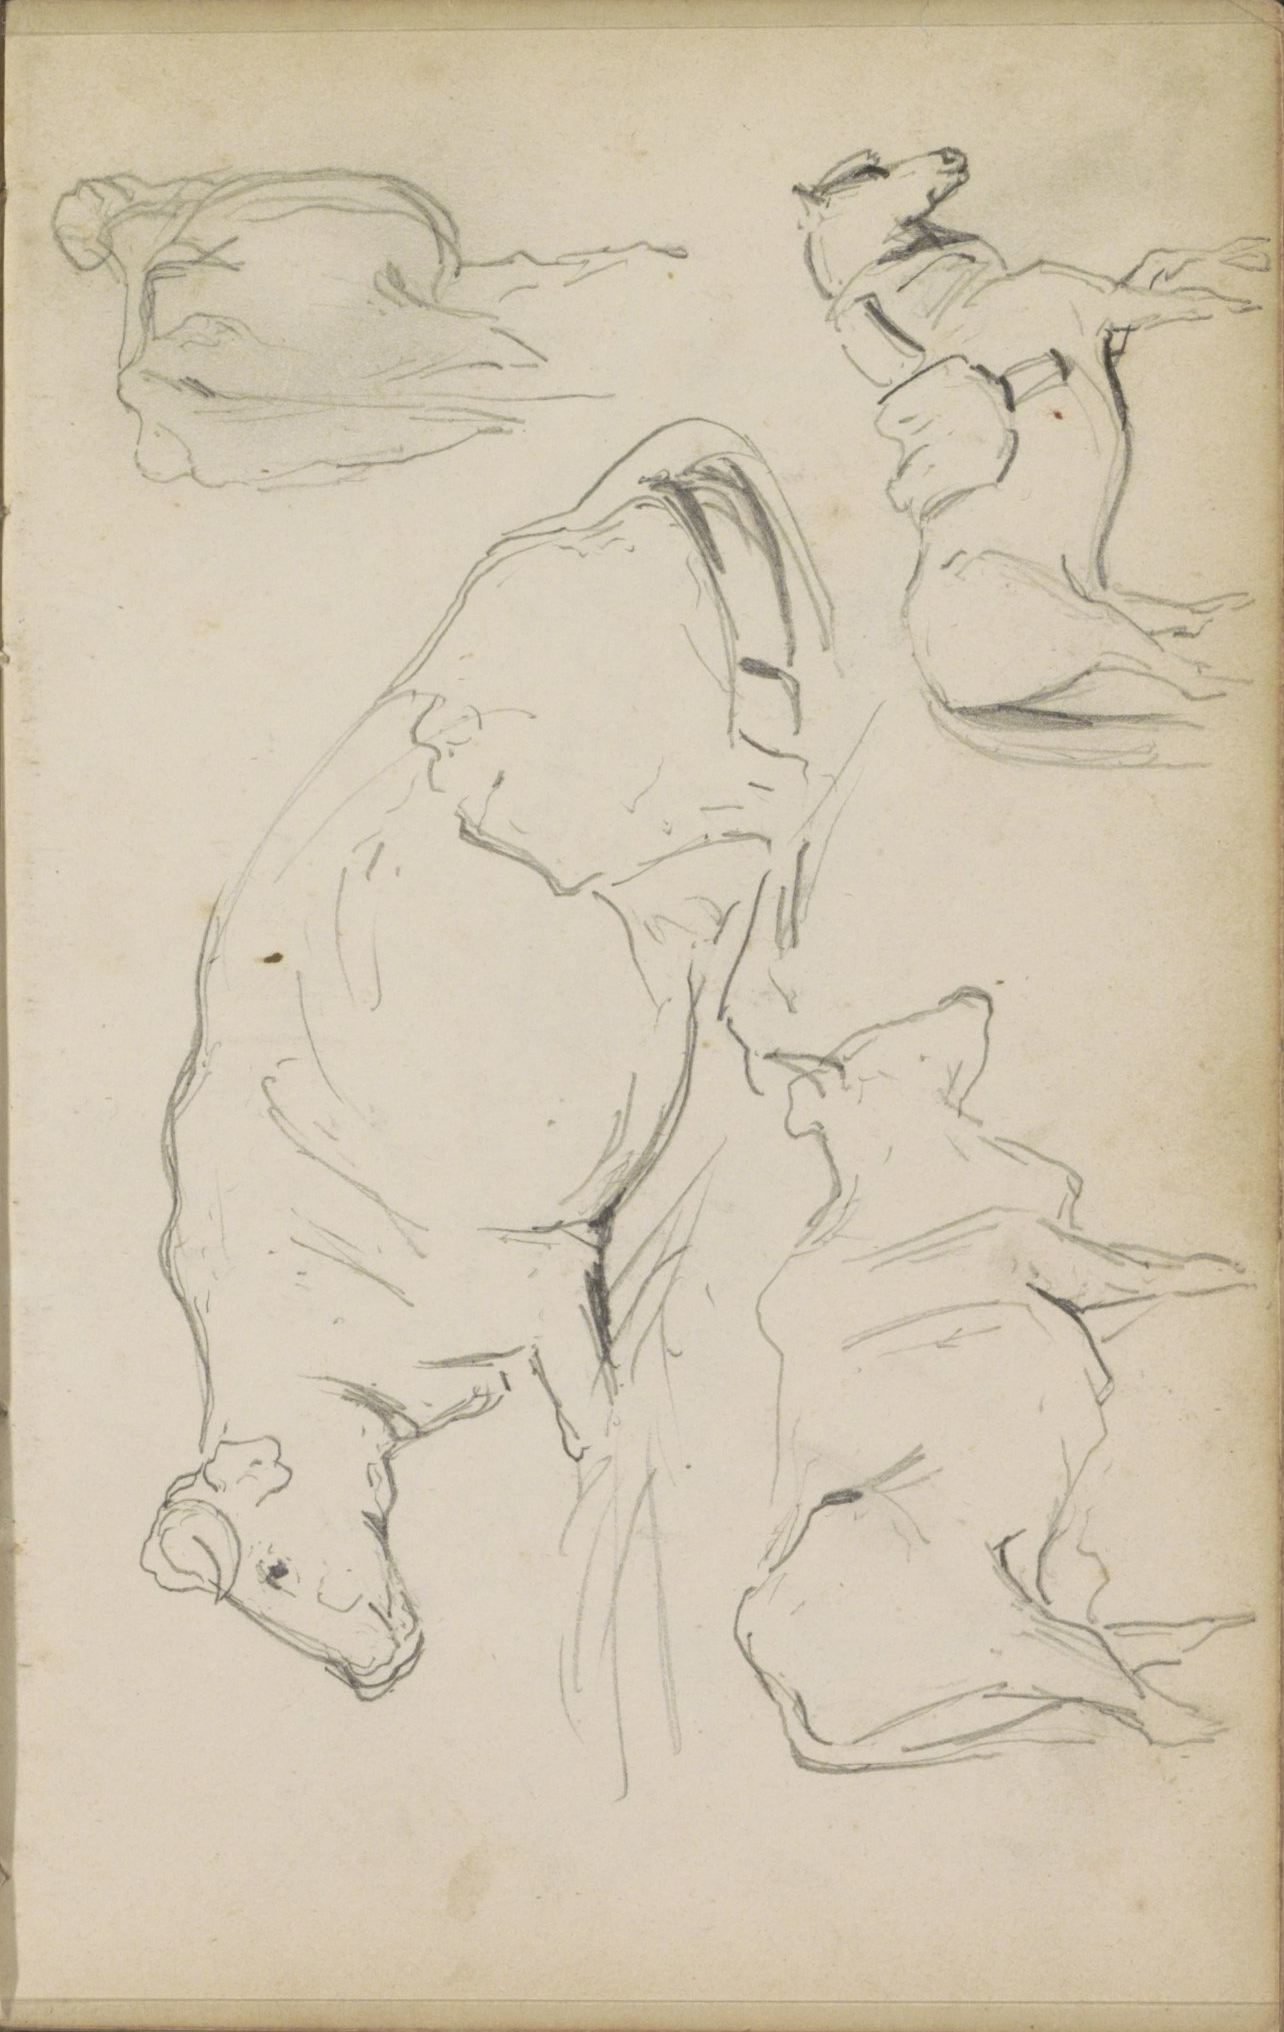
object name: sketchbook leaf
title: Koeien en een gezadeld paard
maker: johannes tavenraat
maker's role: draughtsman, painter, print maker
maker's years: 1809-1881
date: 1839-1872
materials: paper, pencil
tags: cow, horse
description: Blad 48 recto uit een schetsboek met 72 bladen.